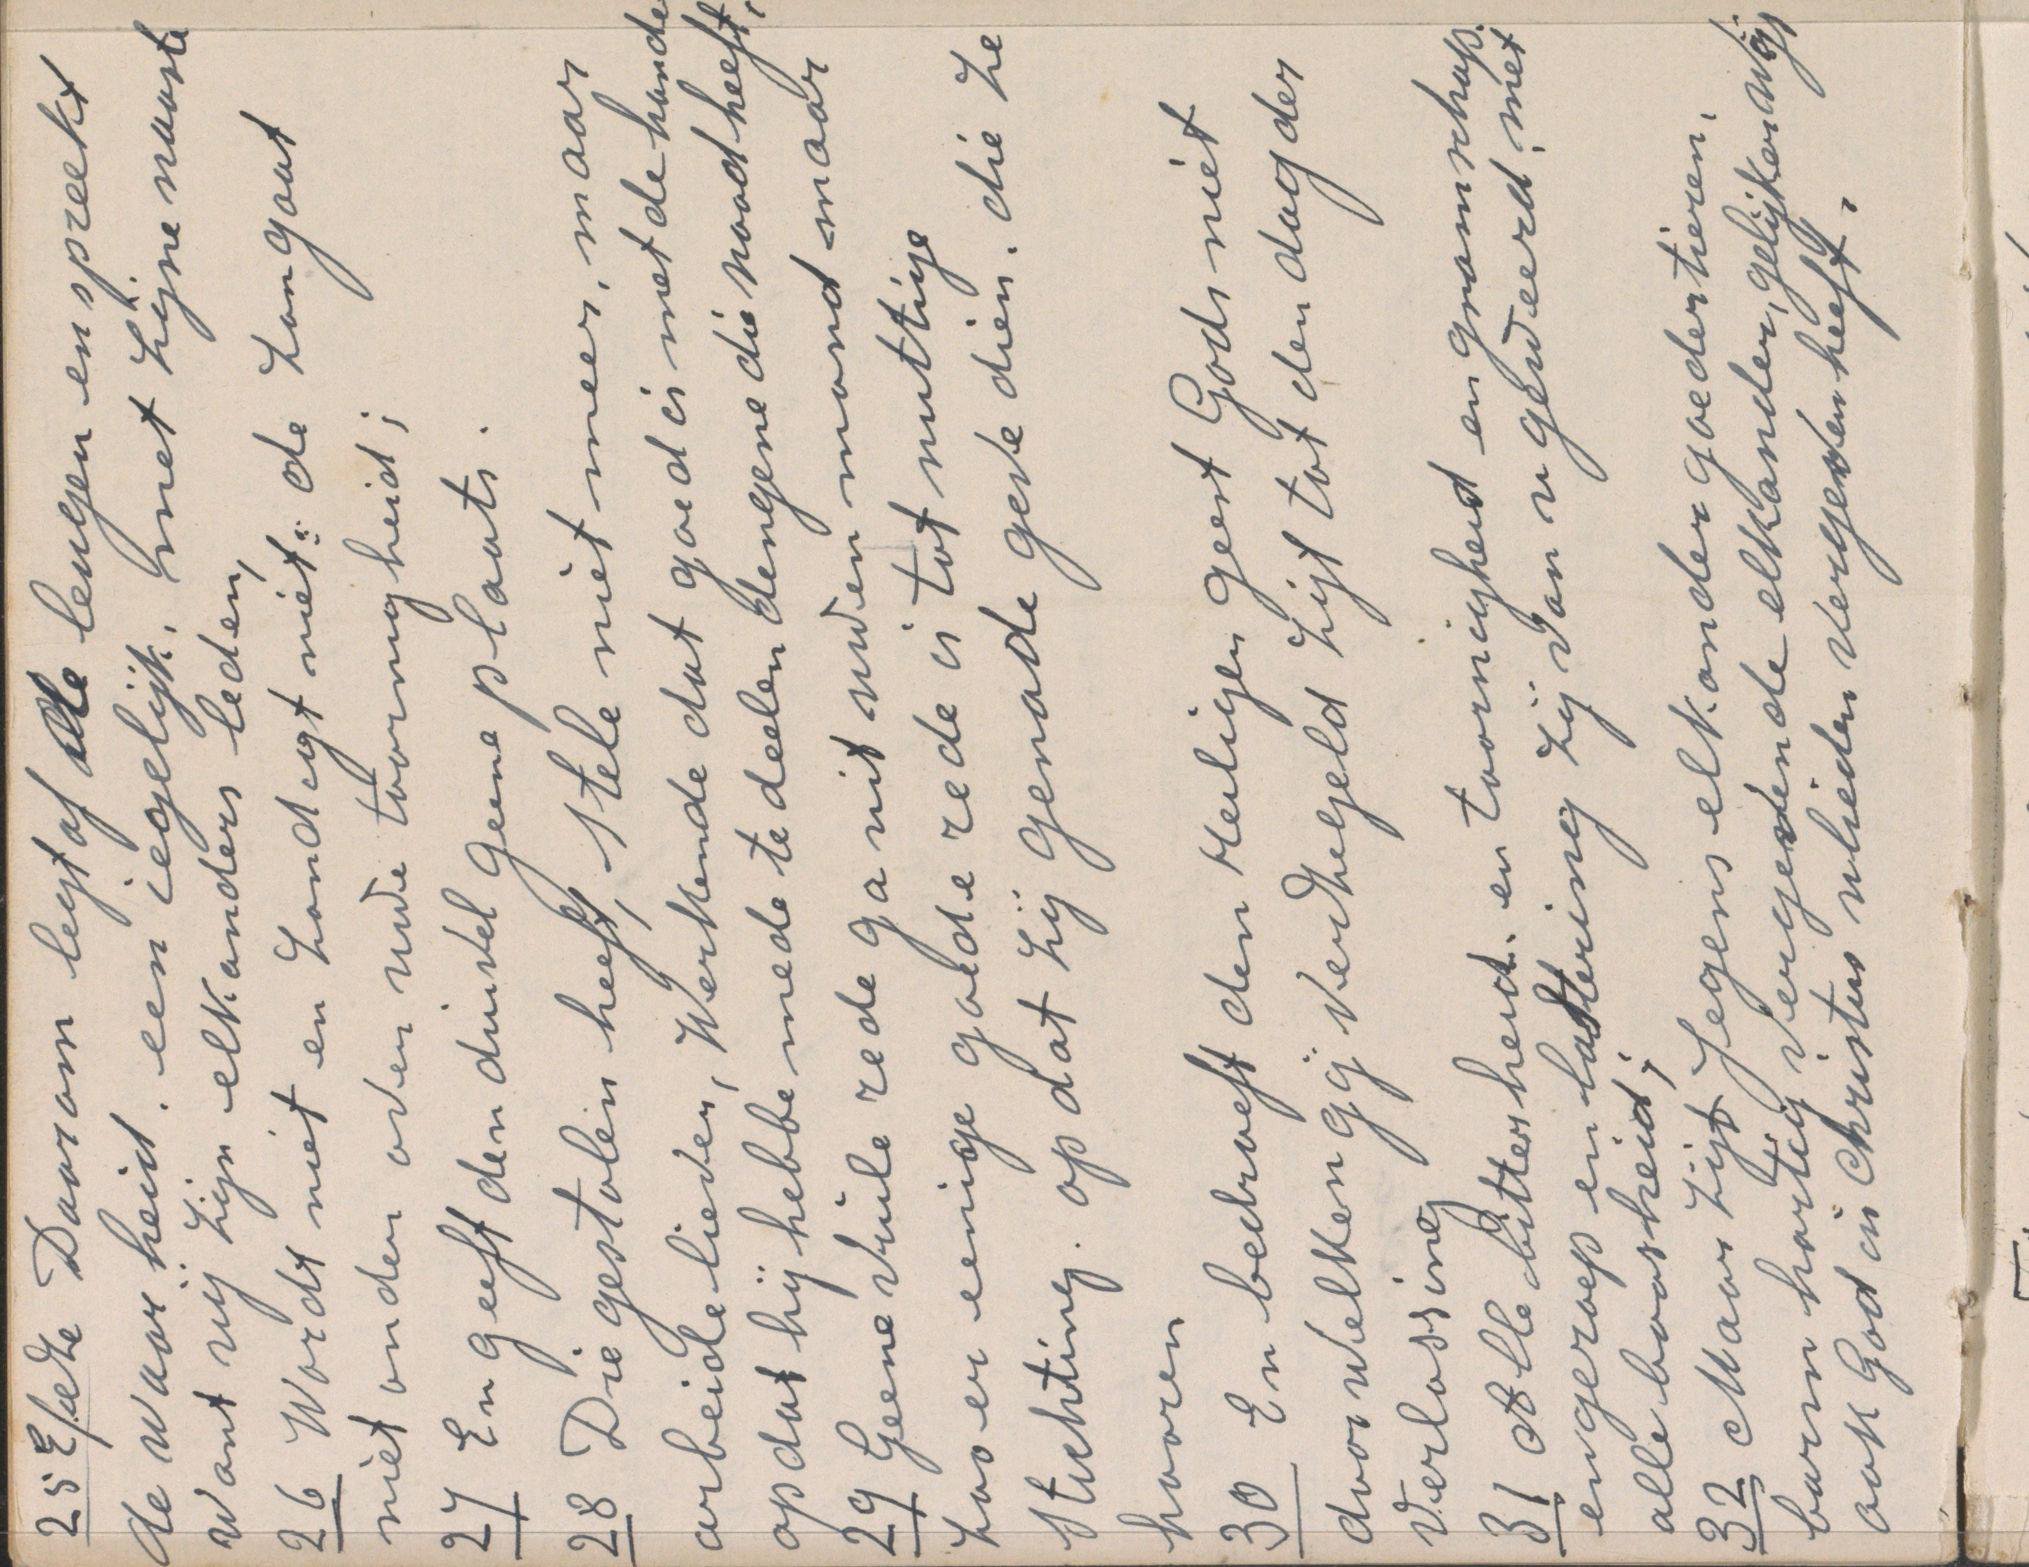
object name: sketchbook leaf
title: Bijbelverzen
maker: marie jordan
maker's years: 1866-1948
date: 1906-1948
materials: ink, paper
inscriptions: annotation: ‘[...]’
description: Pagina 15 uit een schetsboek met 31 bladen.